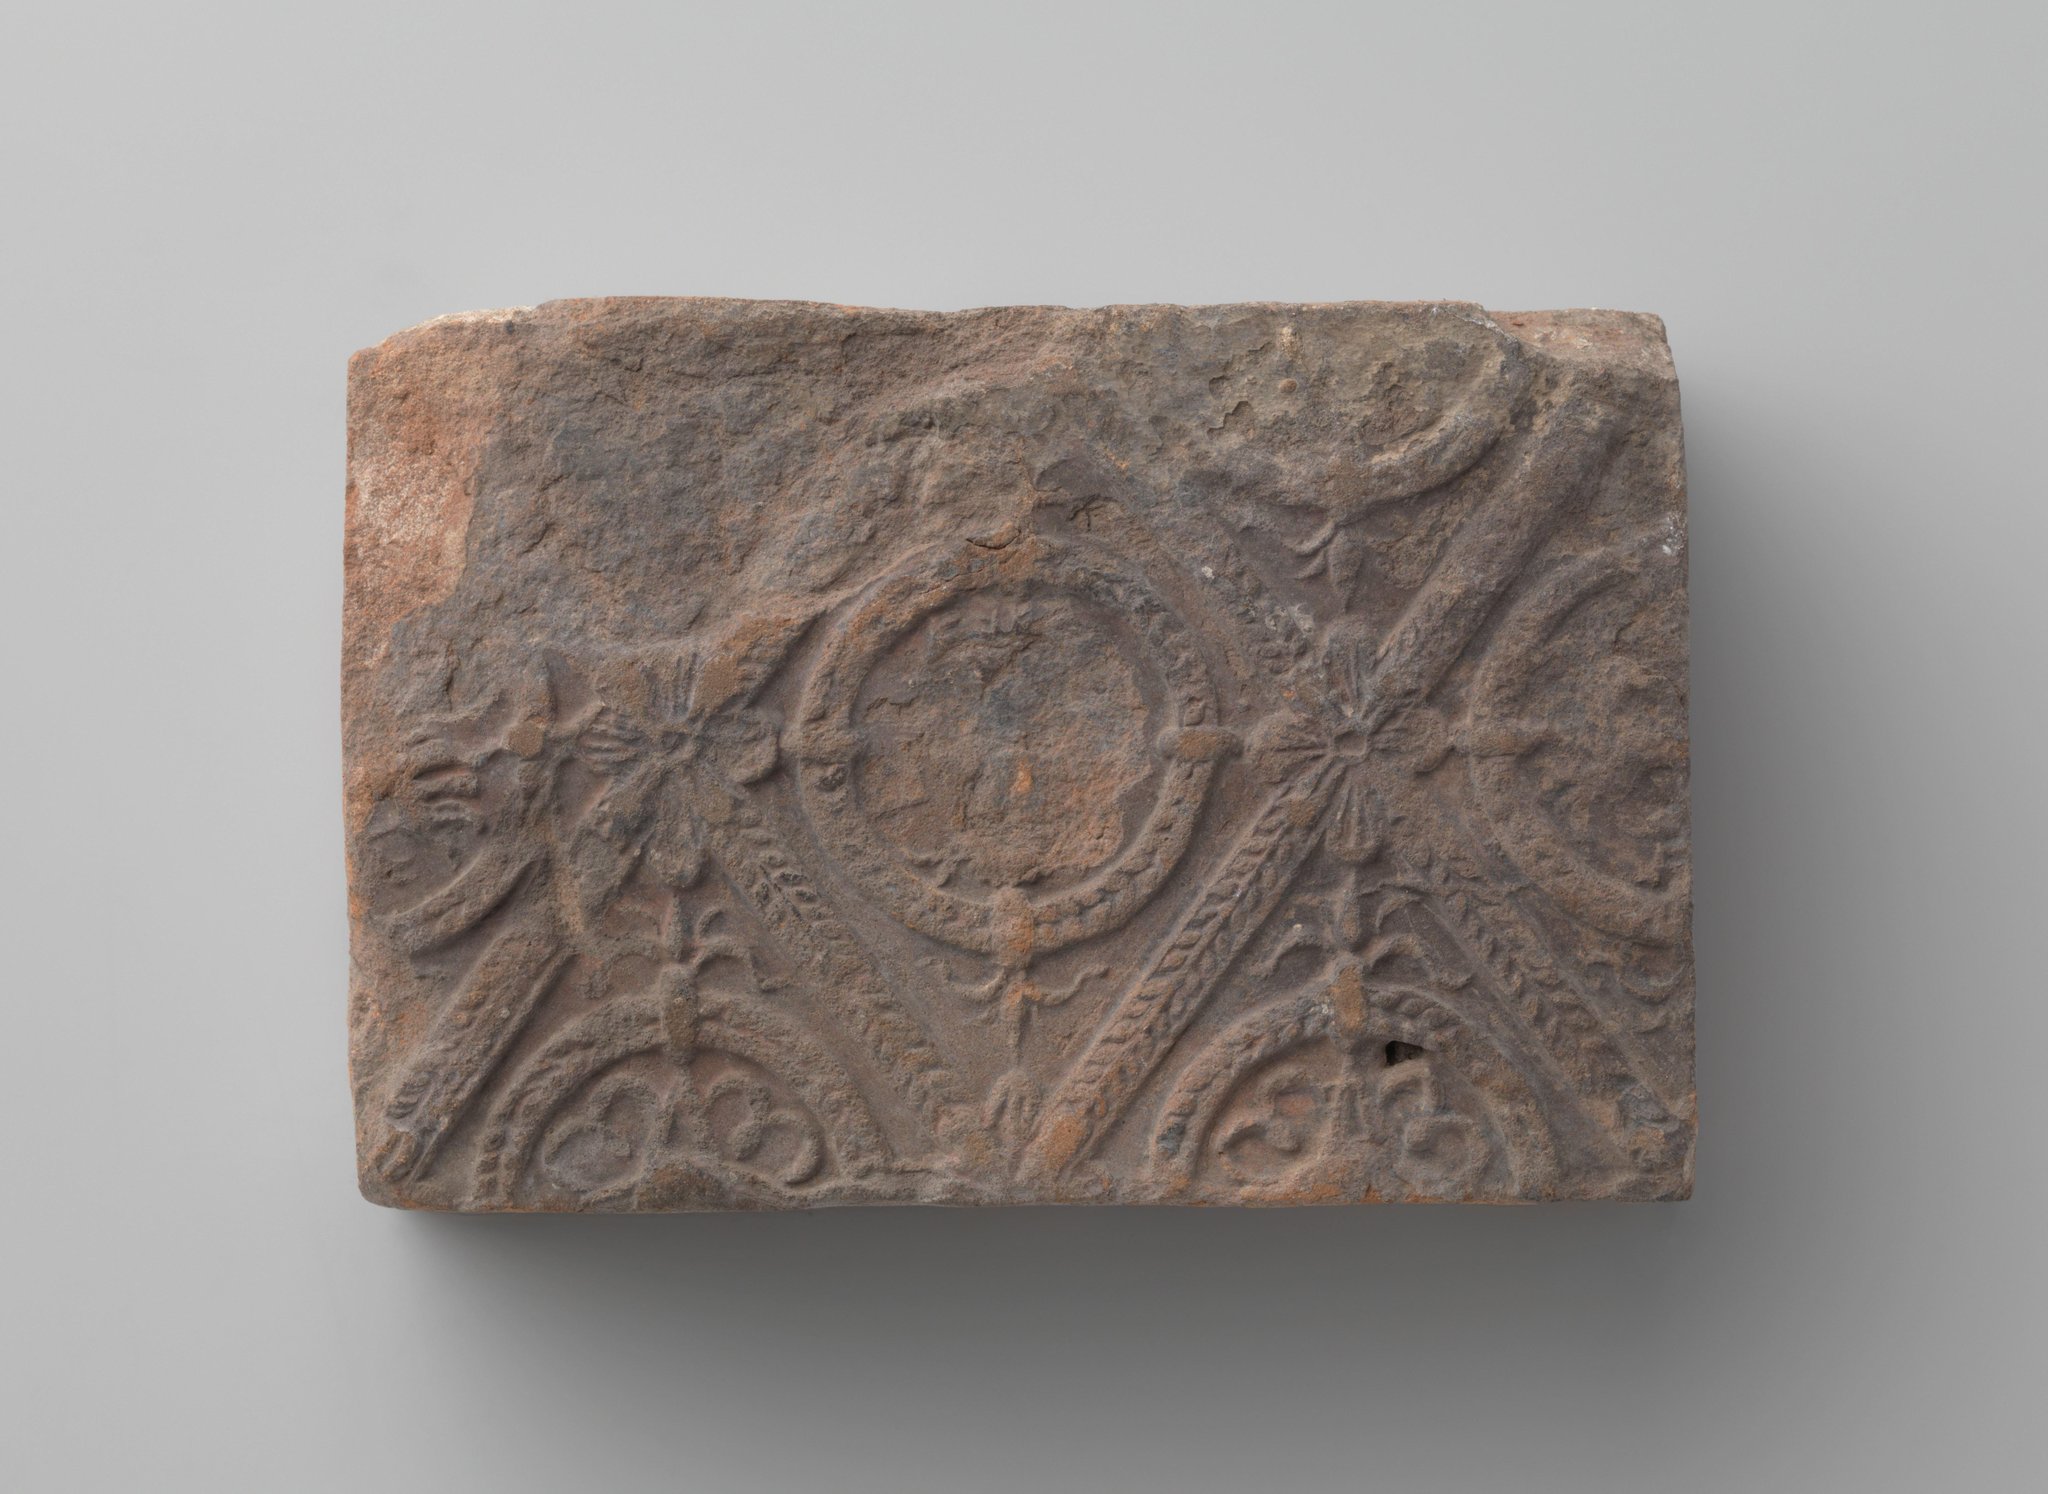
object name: hearthstone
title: Haardsteen met mannenkop en de letters V I in lauwerkrans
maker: Anonymous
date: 1575-1625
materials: earthenware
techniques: printing, firing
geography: southern netherlands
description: Haardsteen met voorstelling van mannenkop en de letters V I in lauwerkrans, geplaatst in geprofileerde ruit. In de halve ruiten aan de zijkanten een dubbelkoppige adelaar. De halve ruiten aan de boven- en onderkant zijn opgevuld met halve medaillons met stermotief.